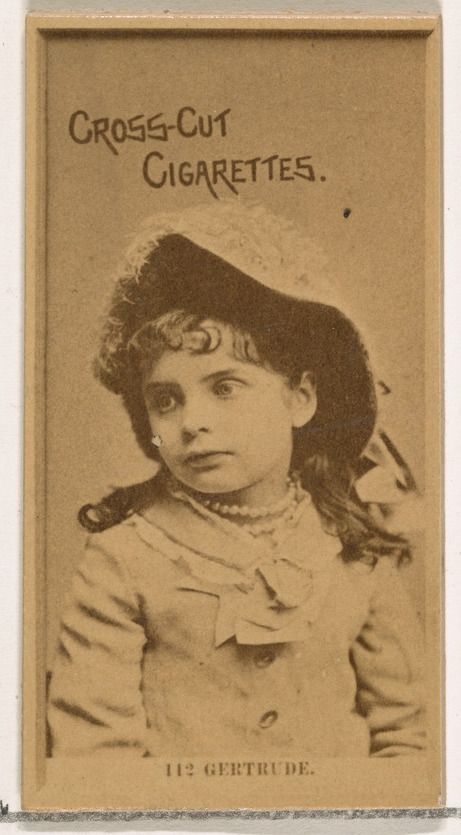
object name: print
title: Card Number 112, Gertrude, from the Actors and Actresses series (N145-2) issued by Duke Sons & Co. to promote Cross Cut Cigarettes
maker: w. duke, sons & co.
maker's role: publisher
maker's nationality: american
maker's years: 1870-1920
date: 1880-1889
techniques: albumen silver print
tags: girls,portraits,actresses